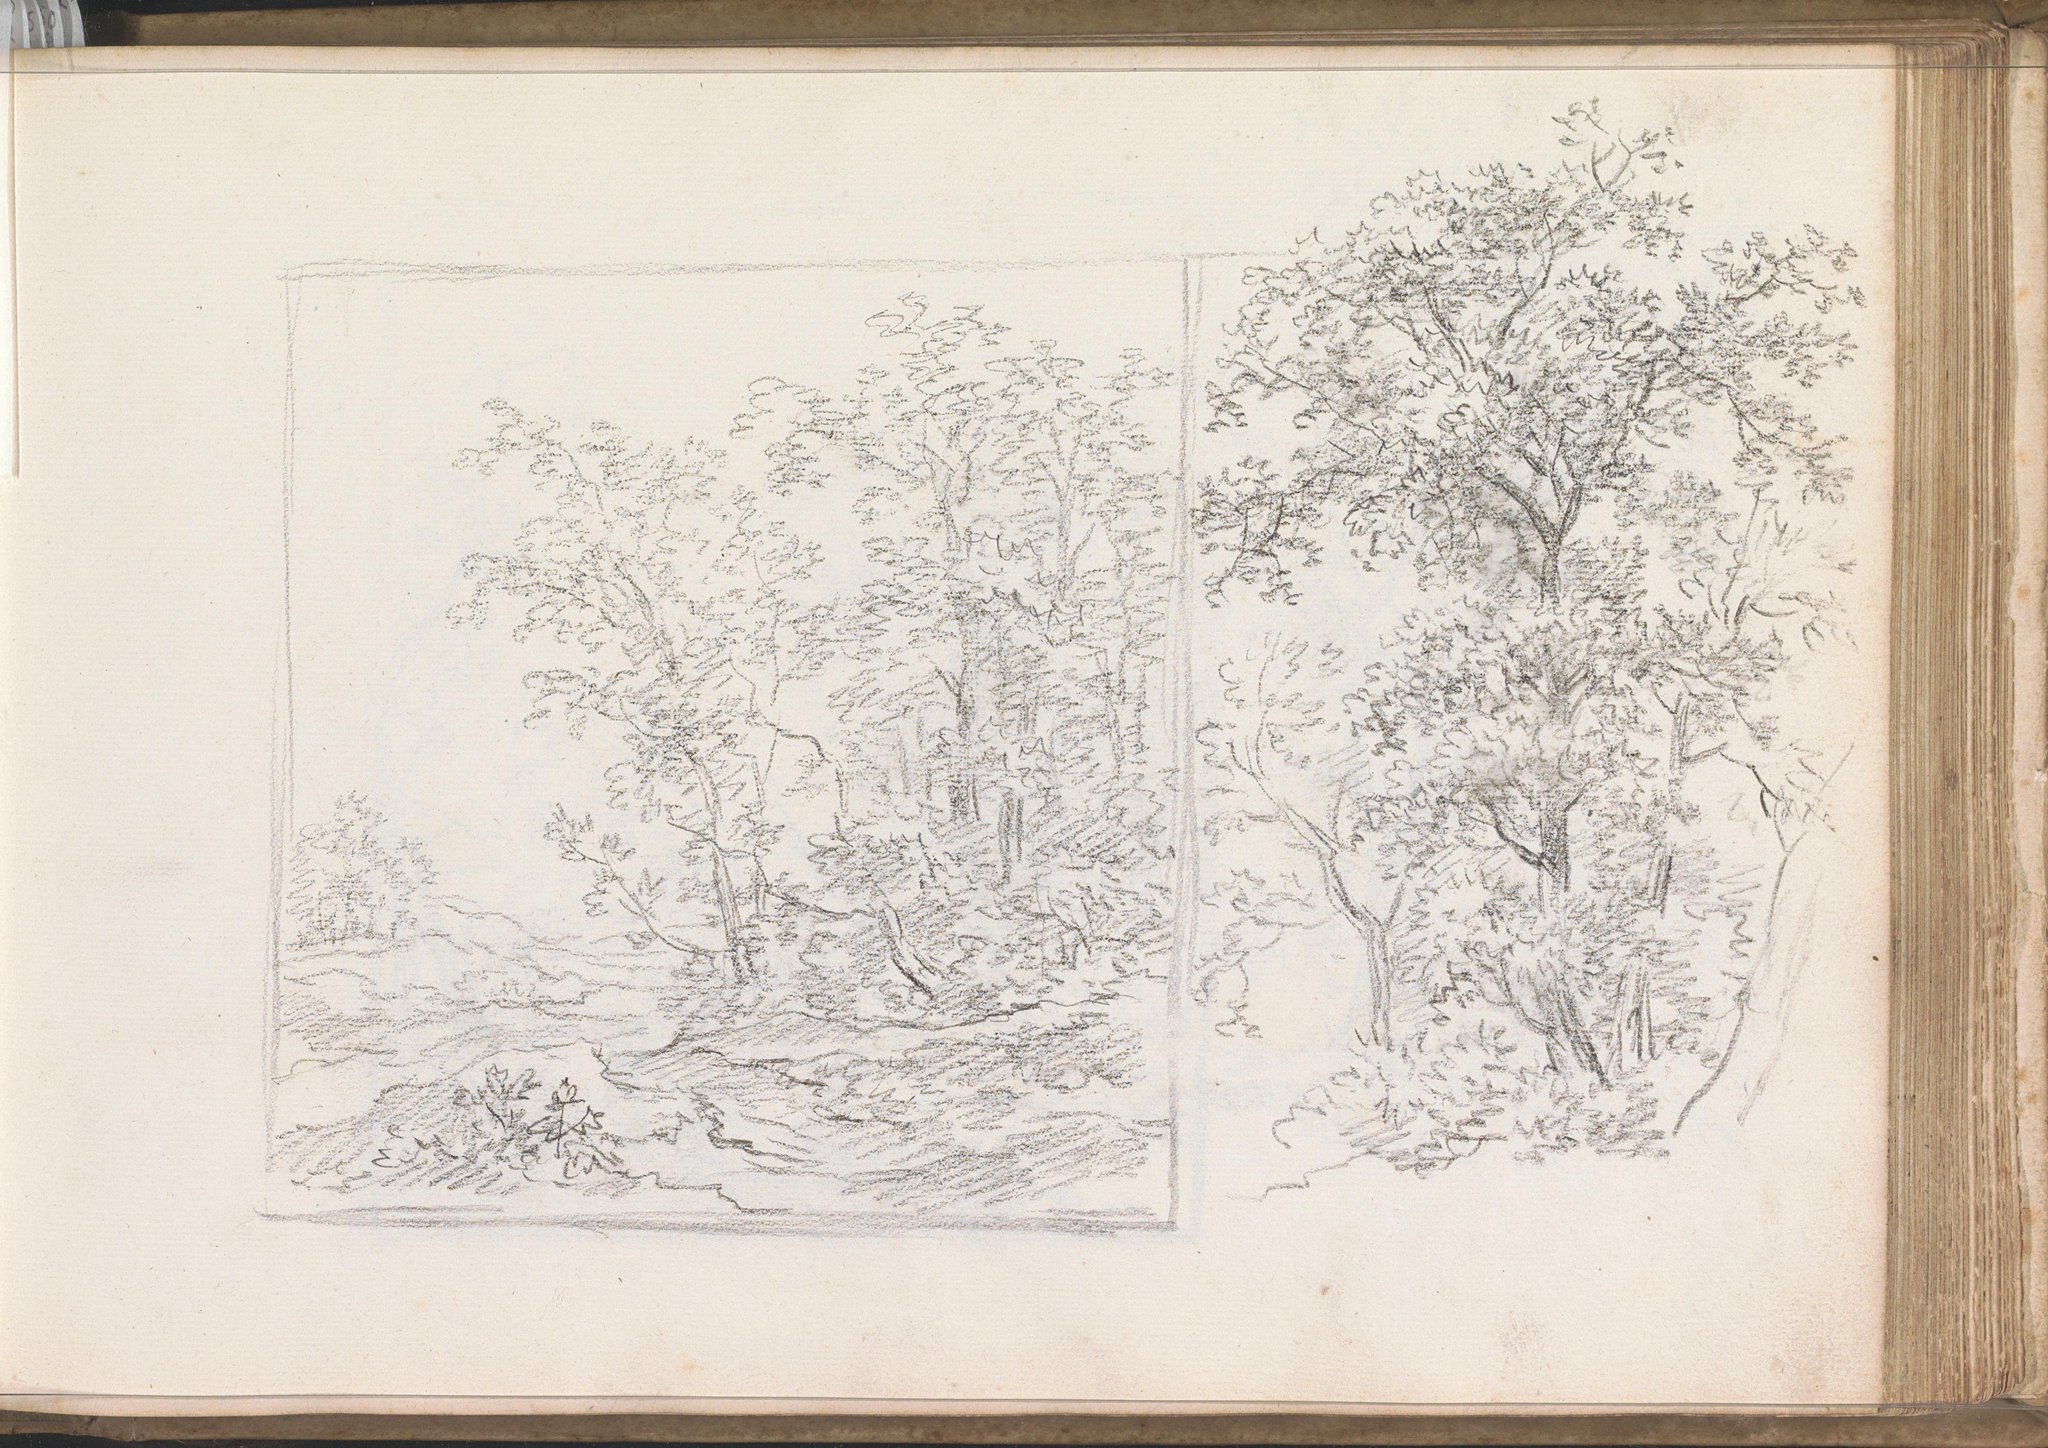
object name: sketchbook leaf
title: Bomengroep en een heuvellandschap met bomen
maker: andreas schelfhout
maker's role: draughtsman, painter, print maker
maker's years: 1787-1870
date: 1811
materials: chalk, paper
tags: low hill country, trees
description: Blad 35 recto uit een schetsboek met 75 bladen.